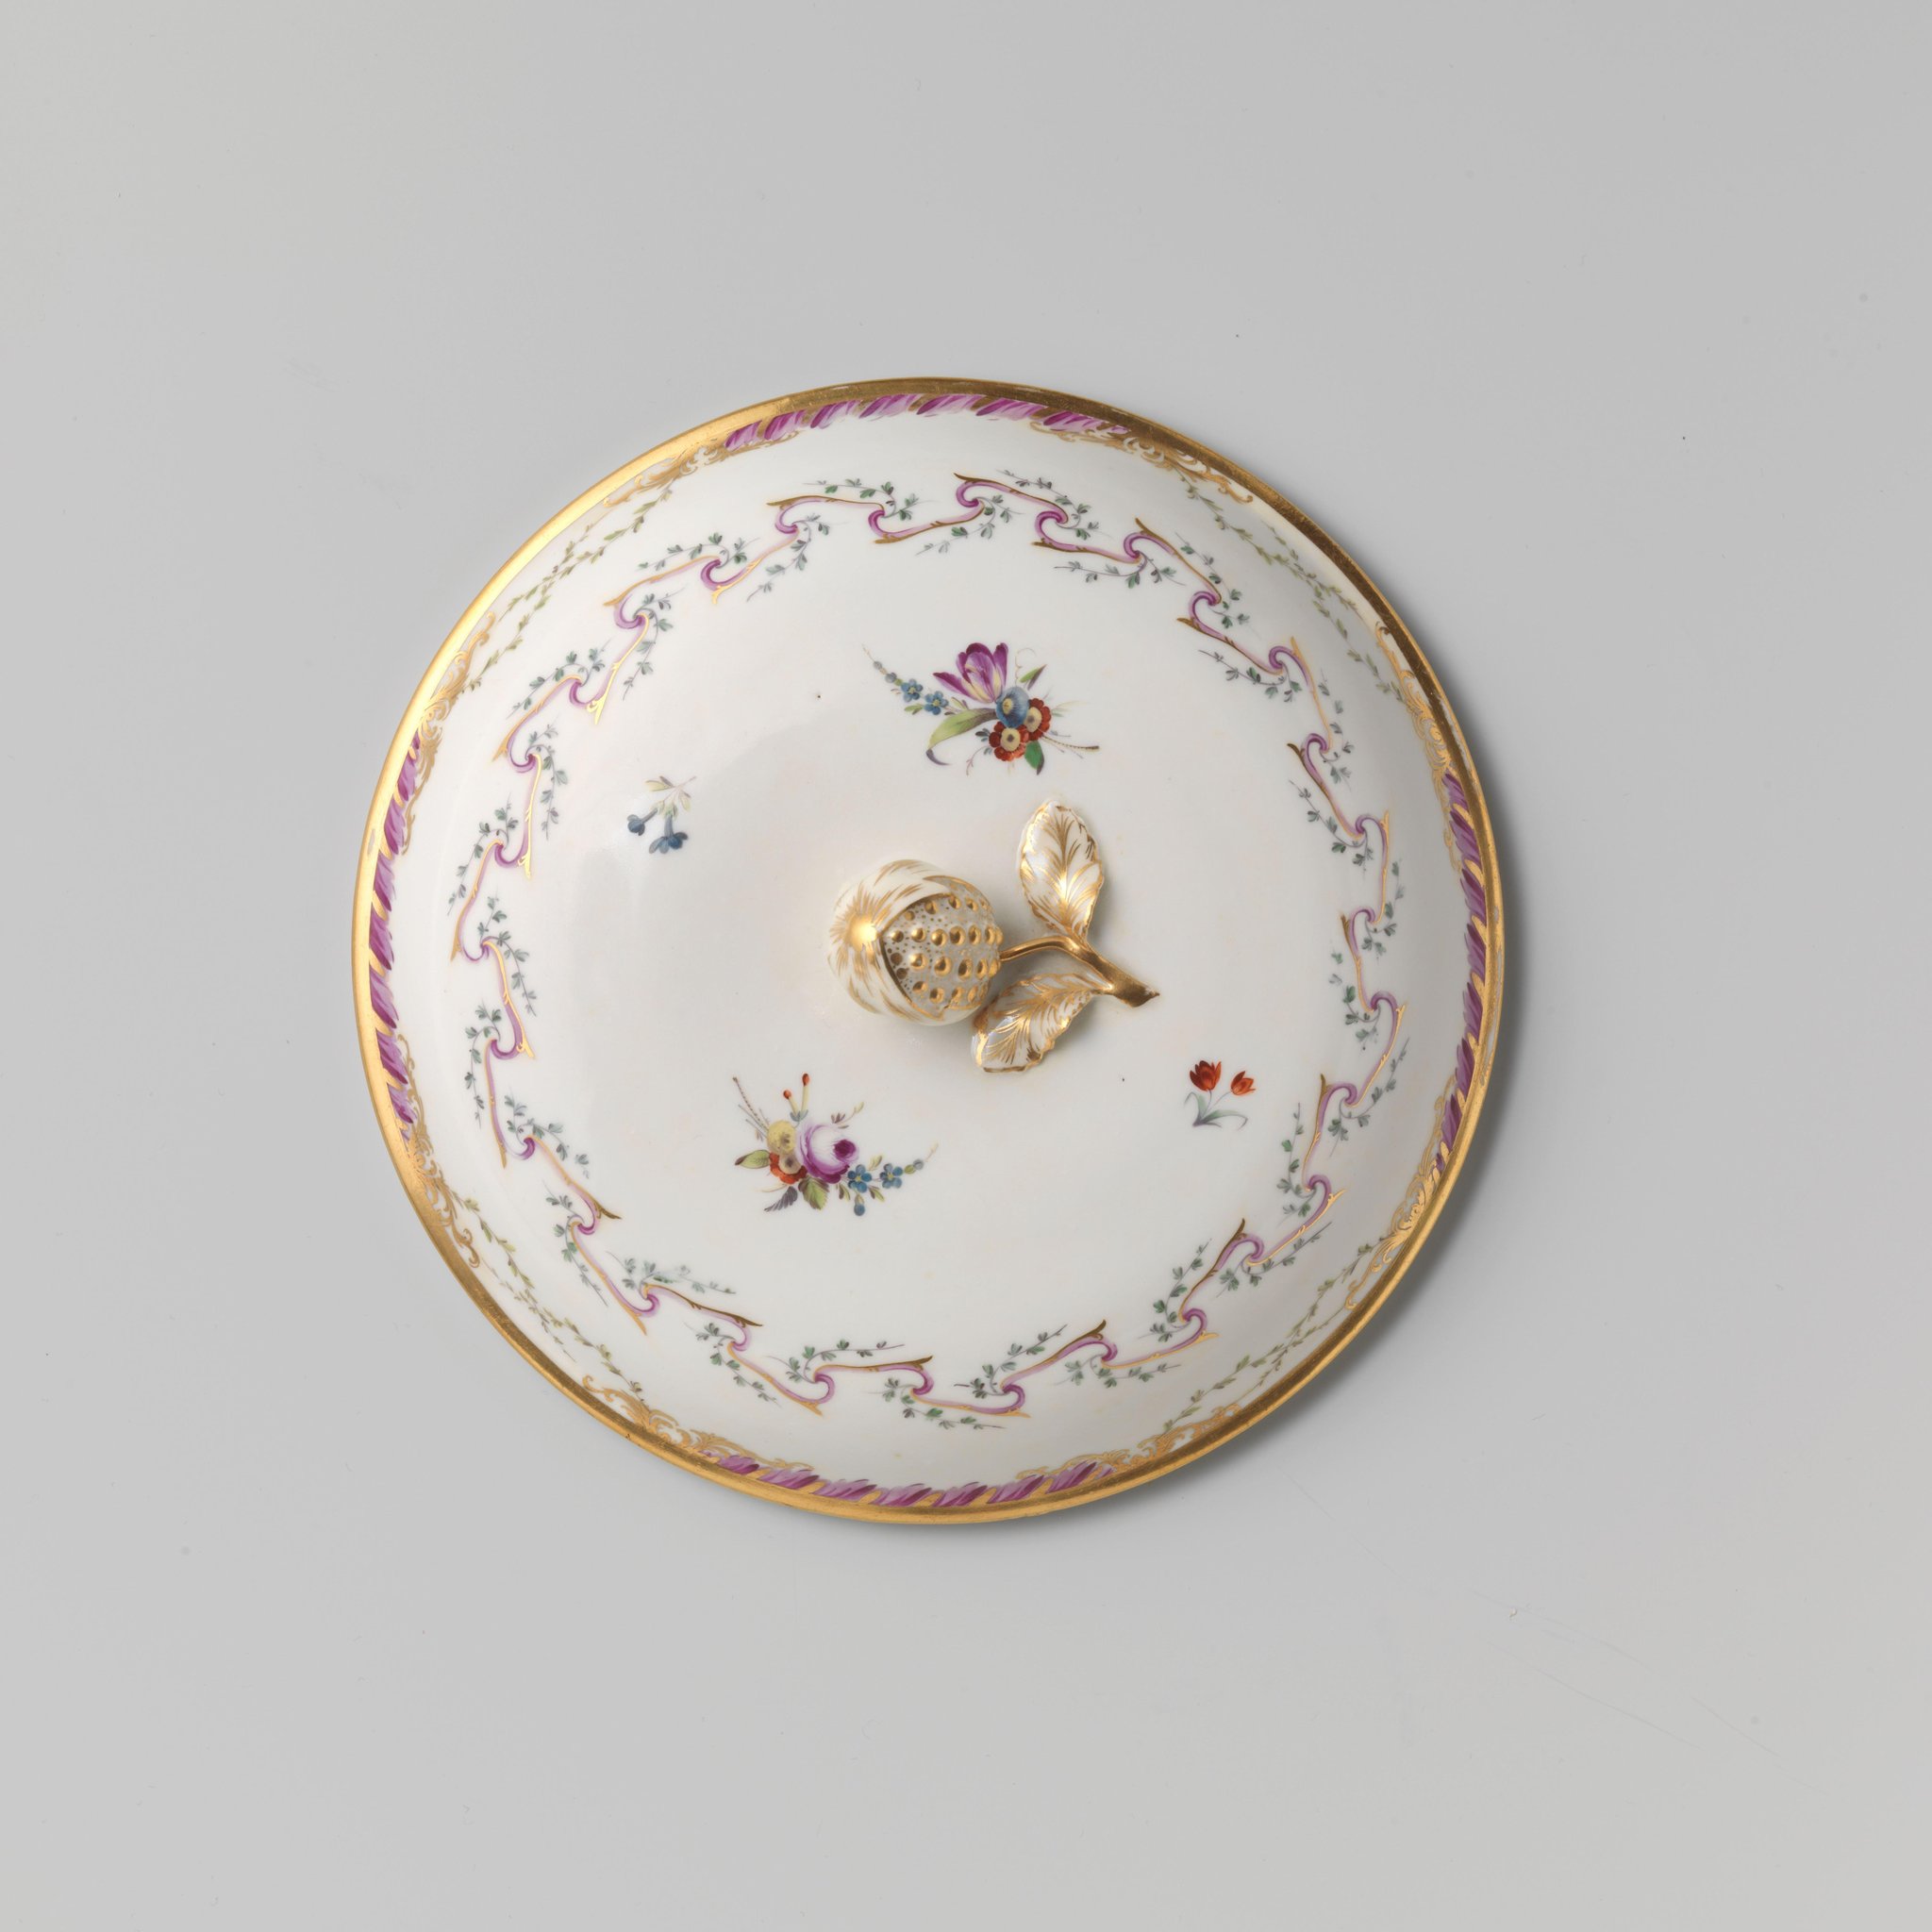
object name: lid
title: Deksel van bak of schaal, rond, en houten steel, behorend bij een servies met geslingerd lintmotief met bladertakken, bloemboeketten en gestrooide bloemtakken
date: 1780-1820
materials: porcelain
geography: loosdrecht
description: Deksel van bak of schaal, rond, behorend bij een servies van porselein, versierd met een geslingerd lintmotief in paars en goud met groene bladertakken, bloemboeketten en gestrooide bloemtakken. Dekselknop in de vorm van een vrucht met steel en bladeren in goud.